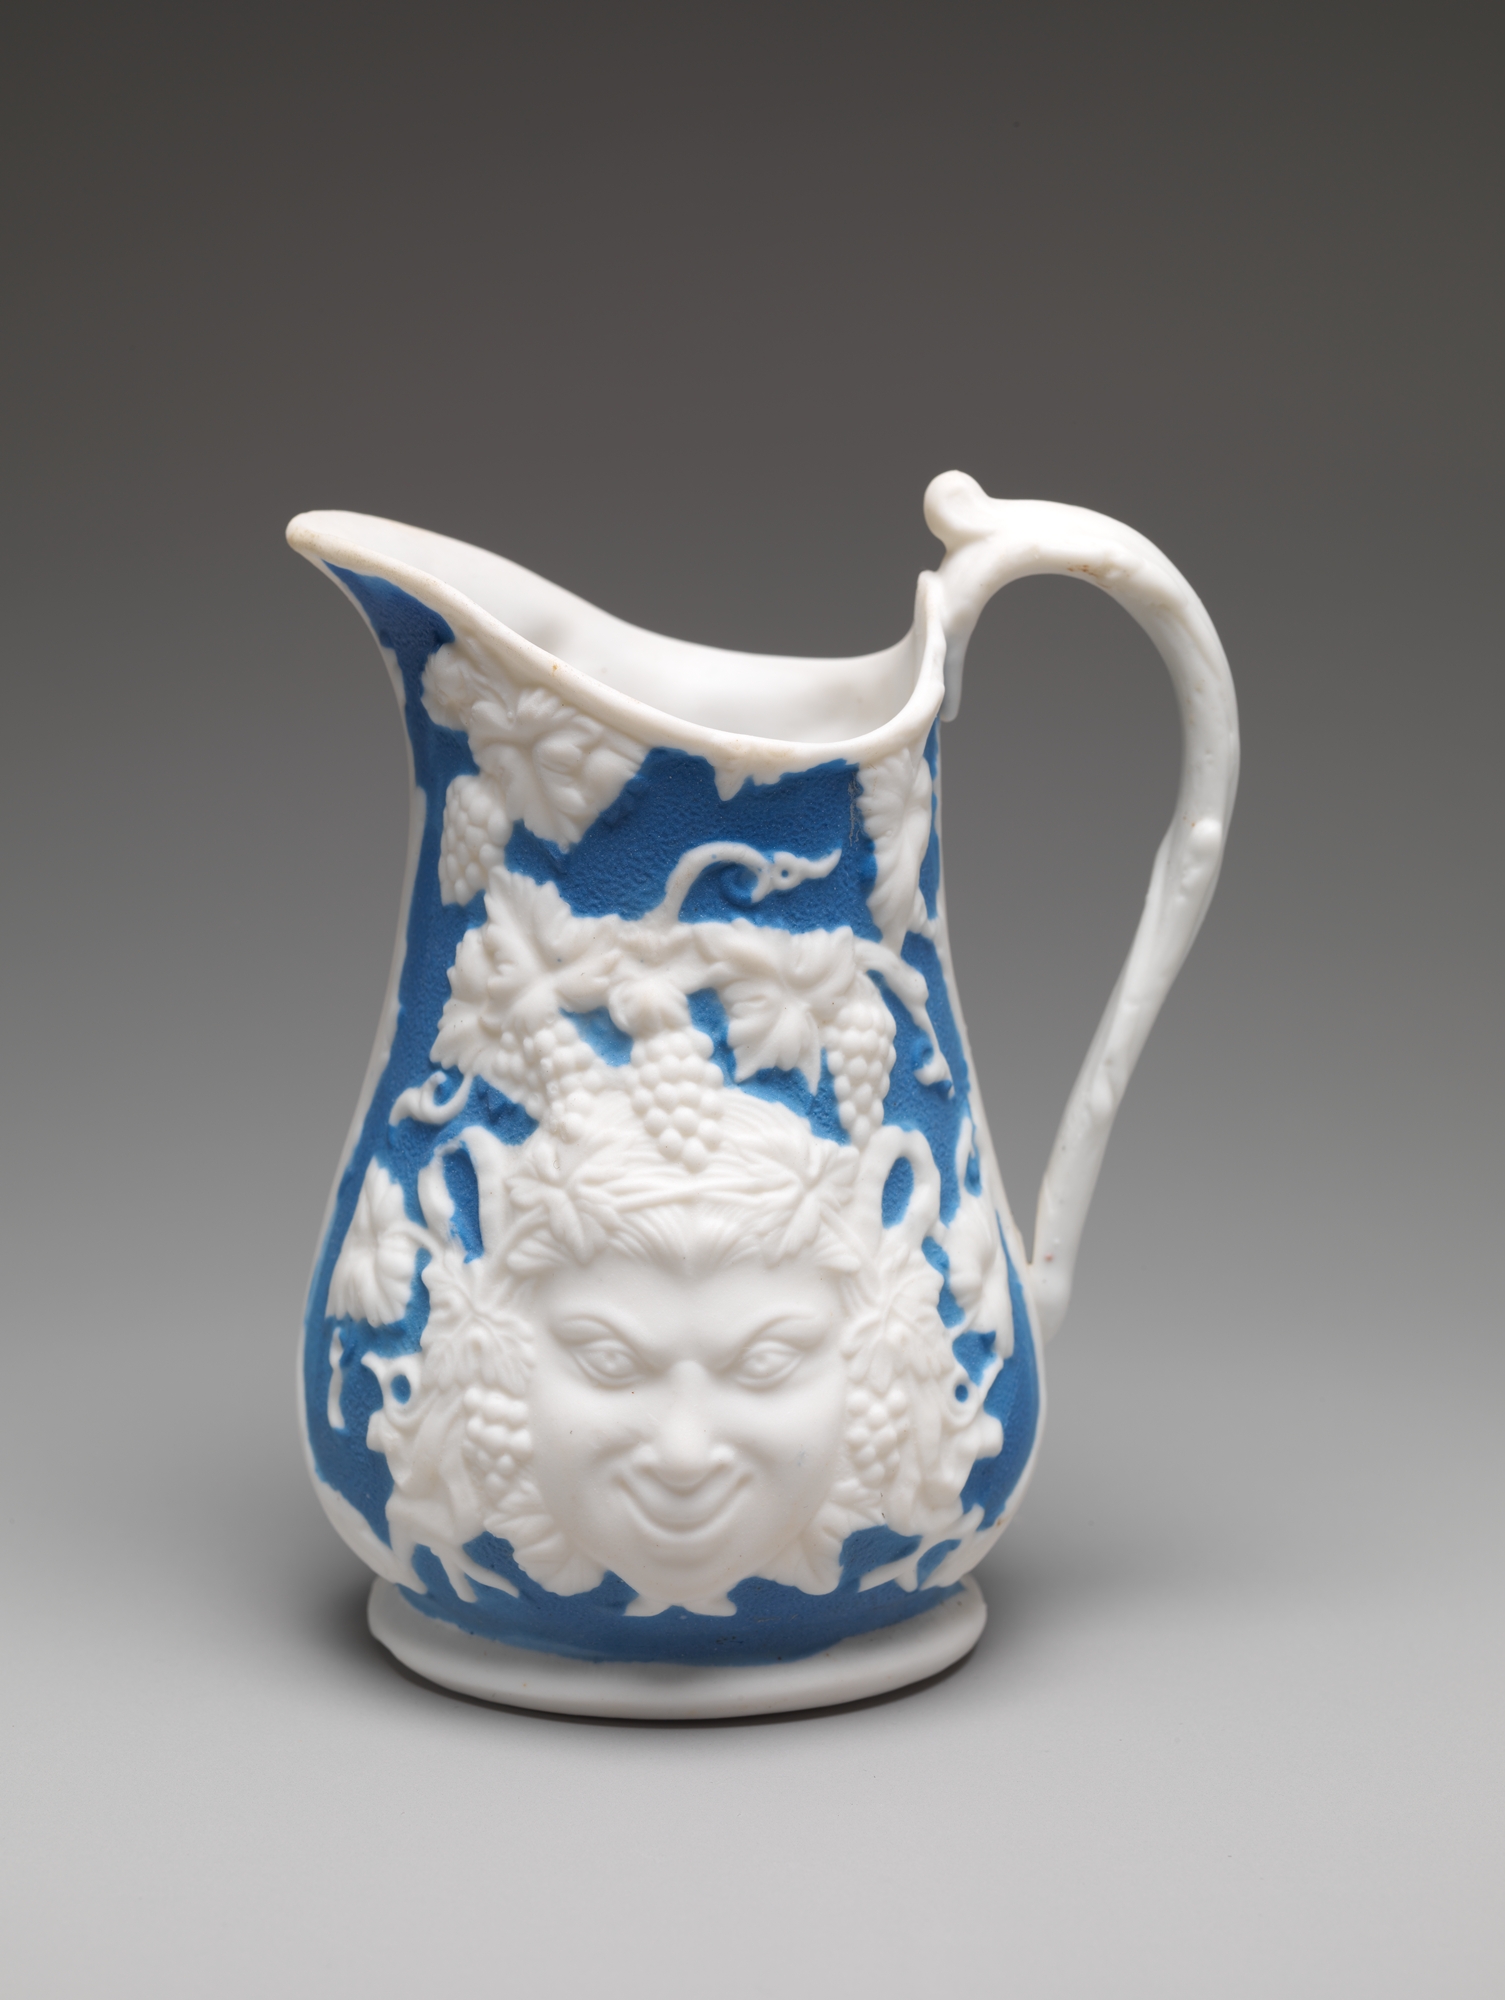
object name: pitcher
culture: american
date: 1830-1870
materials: porcelain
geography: united states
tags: masks,grapes